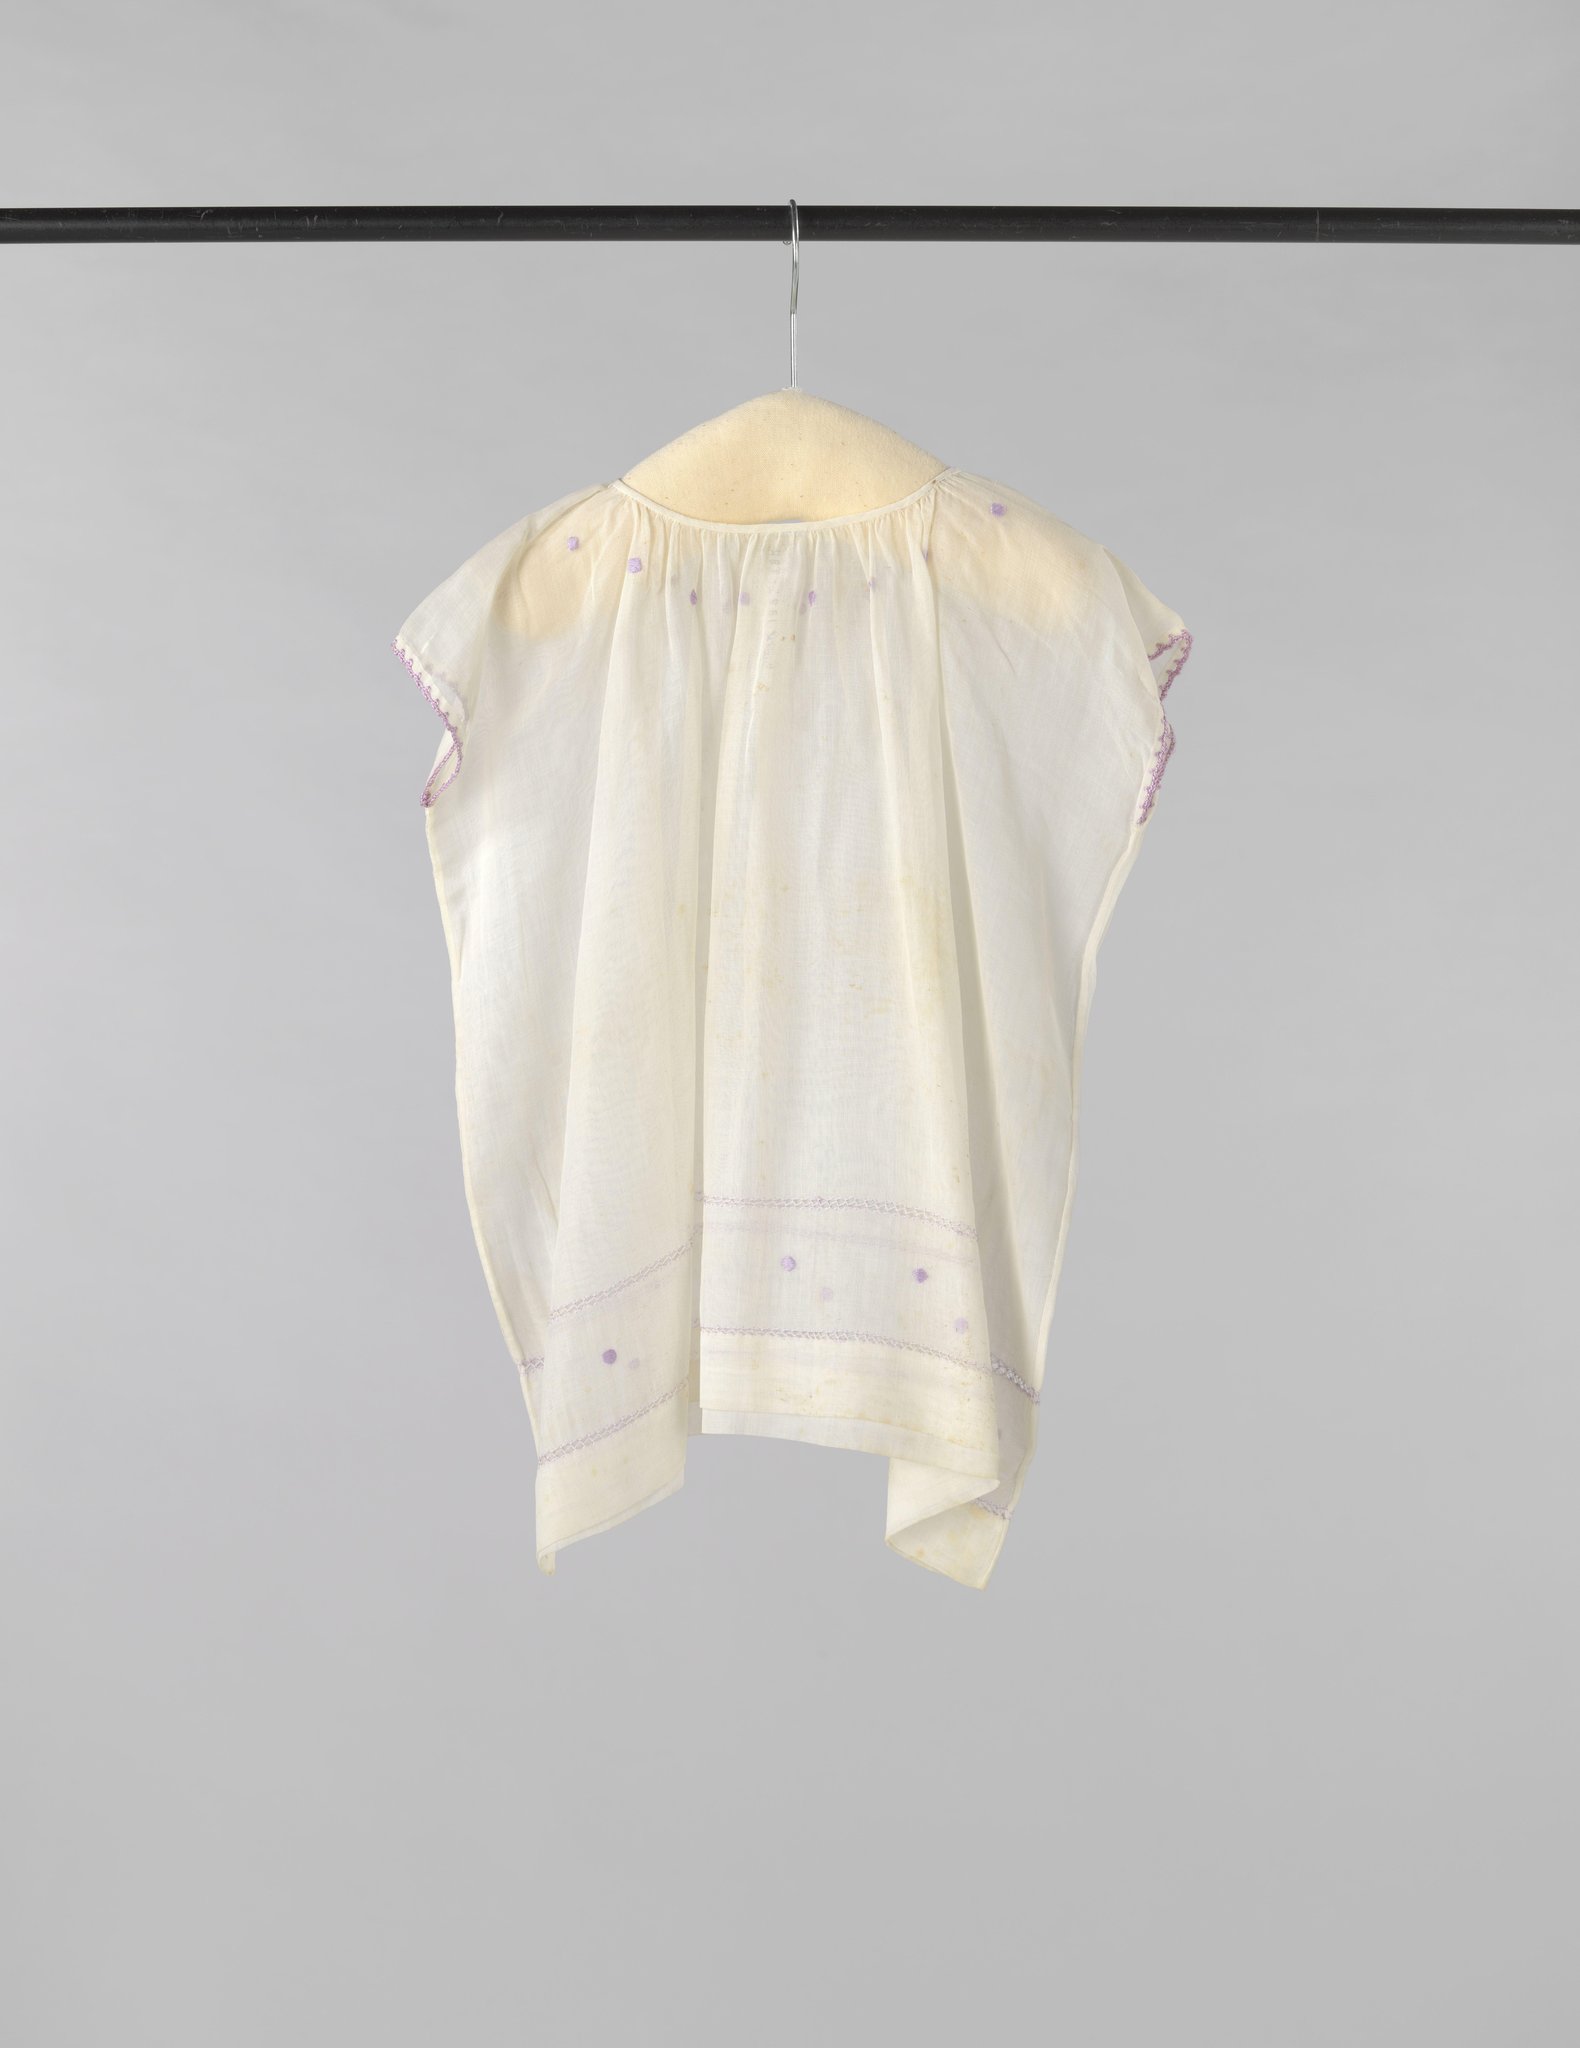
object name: childrenswear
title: Mouwloze kinderjurk van doorzichtig geweven witte katoen (?), versierd met paarse gehaakte ajourranden en paarse geborduurde noppen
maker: Anonymous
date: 1922-1926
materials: cotton, linen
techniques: crochet, embroidered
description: Mouwloze kinderjurk van doorzichtig geweven witte katoen (?), versierd met paarse gehaakte ajourranden en paarse geborduurde noppen.